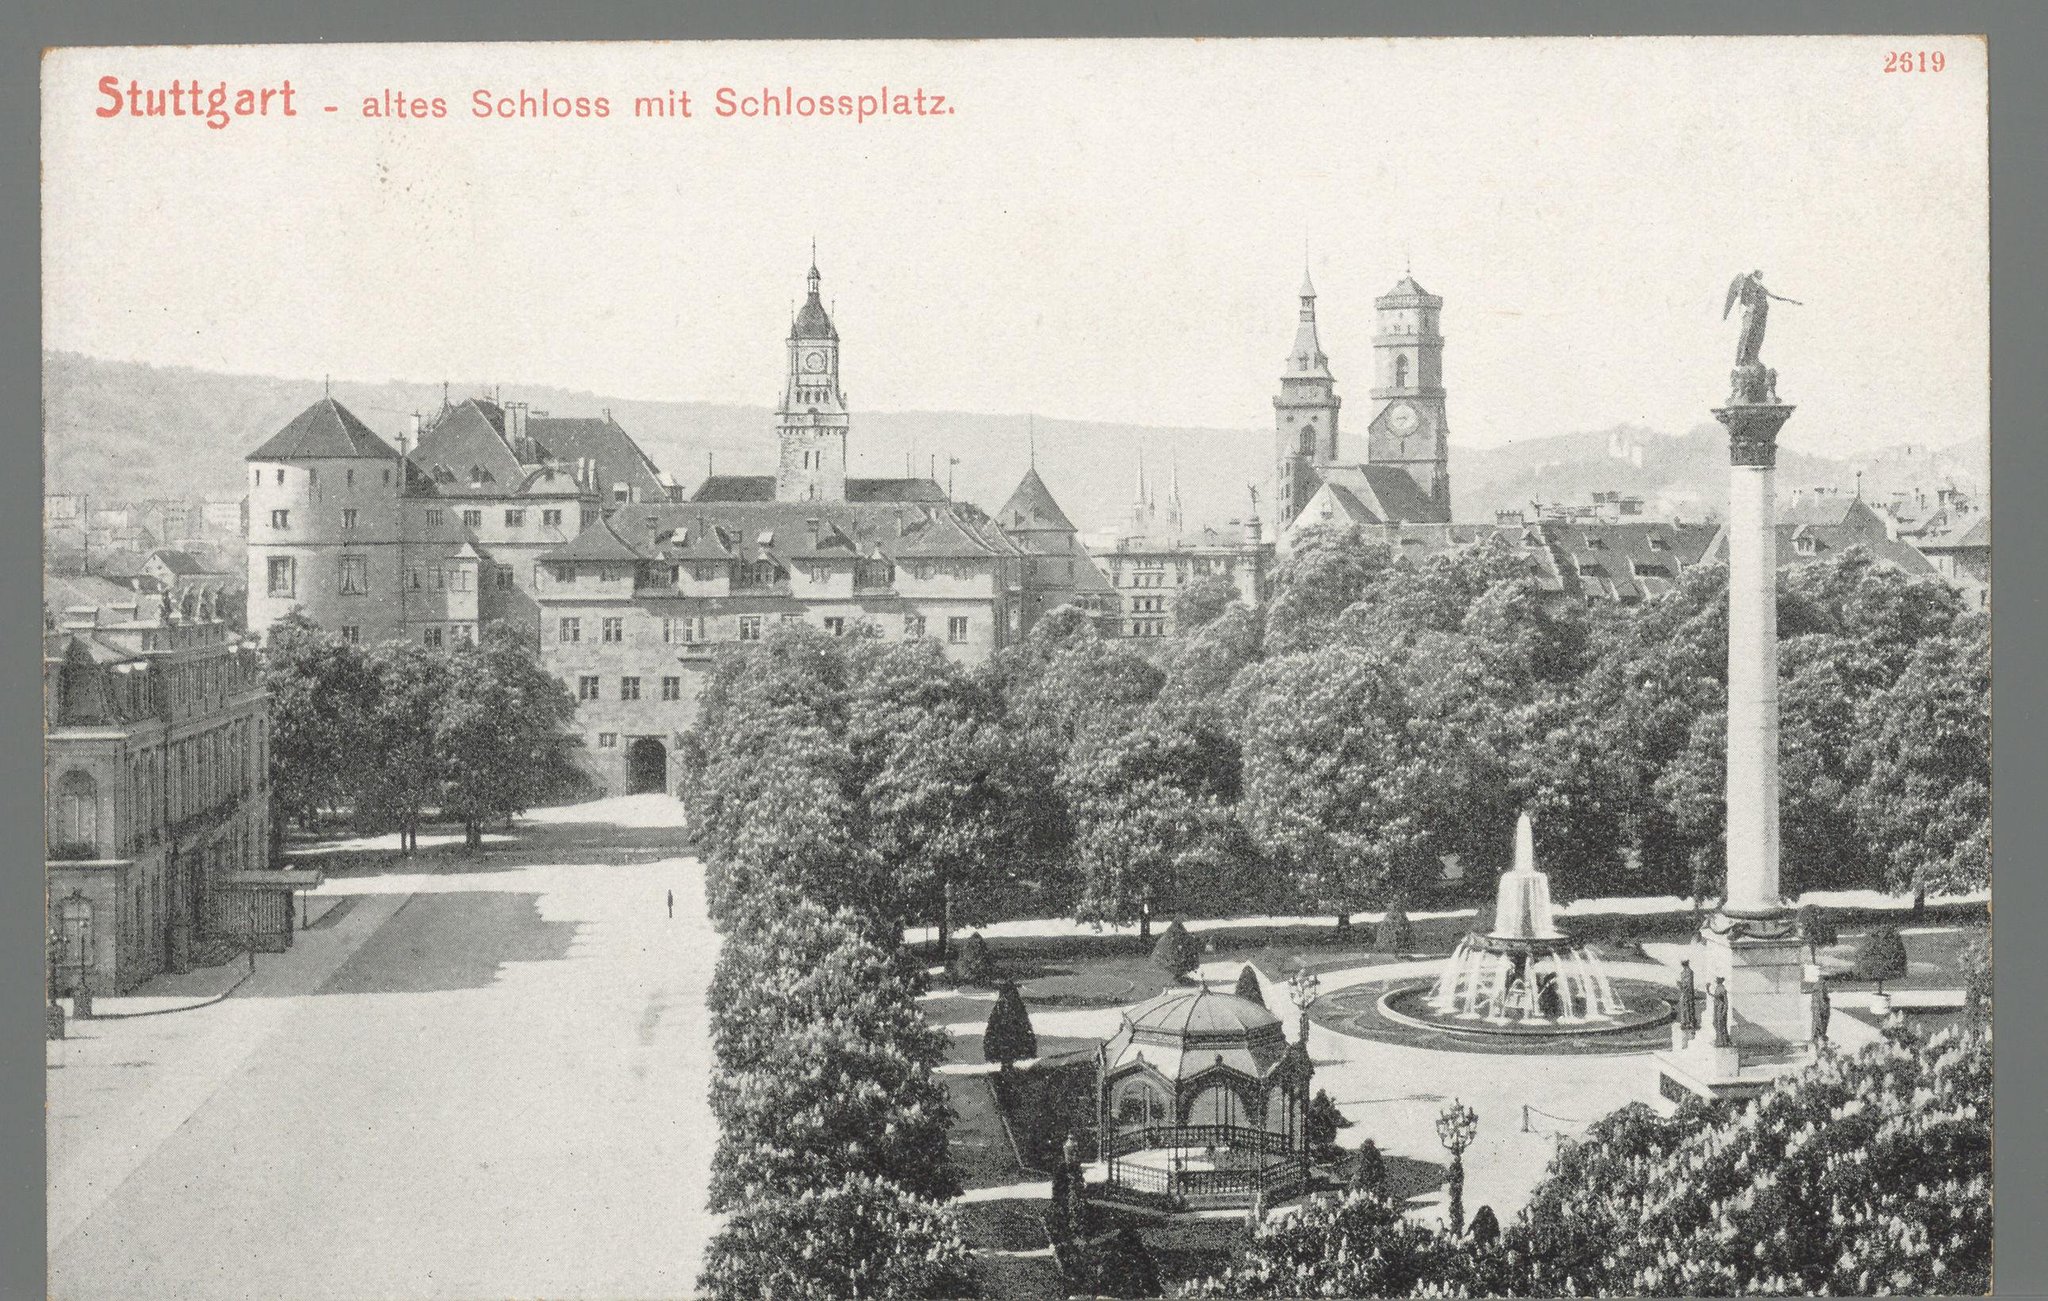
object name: photomechanical print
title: Stuttgart - altes Schloss mit Schlossplatz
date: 1905-1930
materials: cardboard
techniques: autotype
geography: stuttgart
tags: square, place, circus, etc., obelisk, needle, castle, church (exterior), monument, statue, ornamental fountain